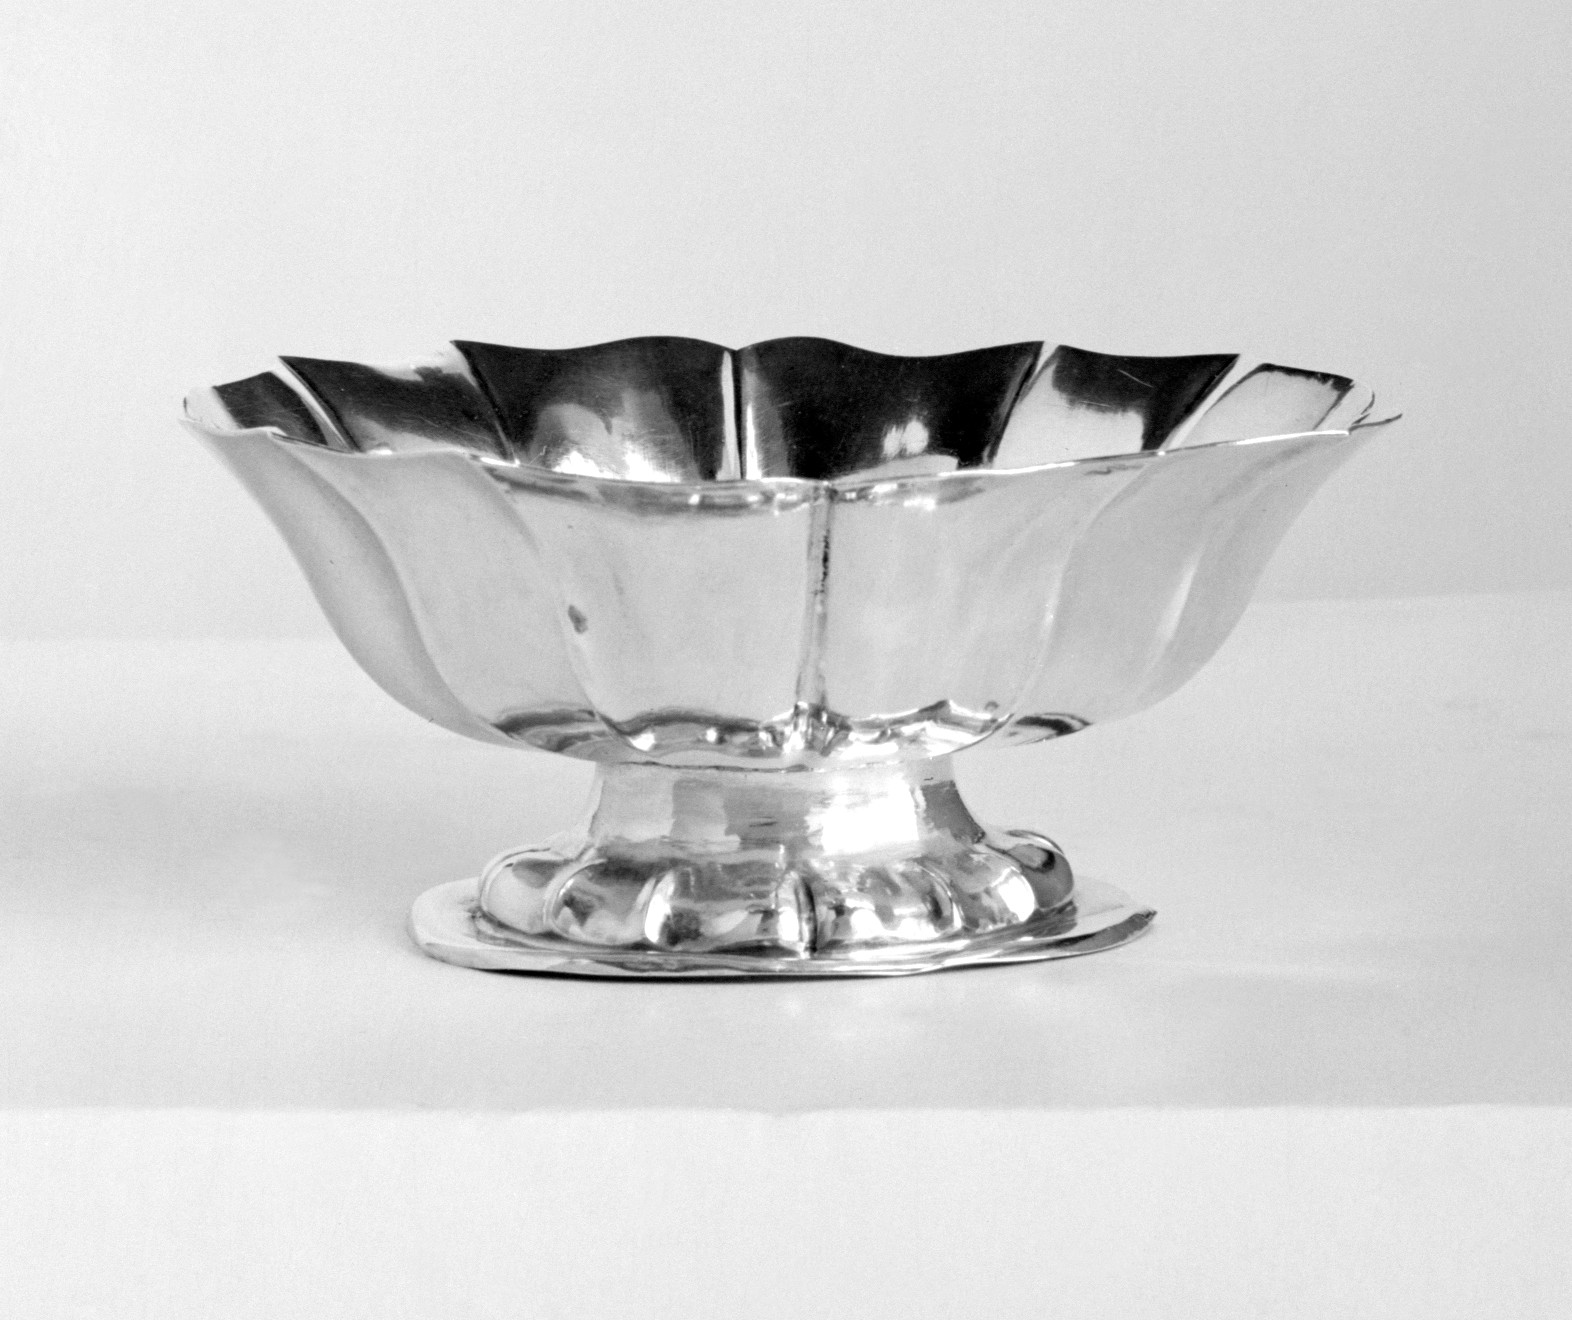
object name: dish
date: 1701-1800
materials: silver